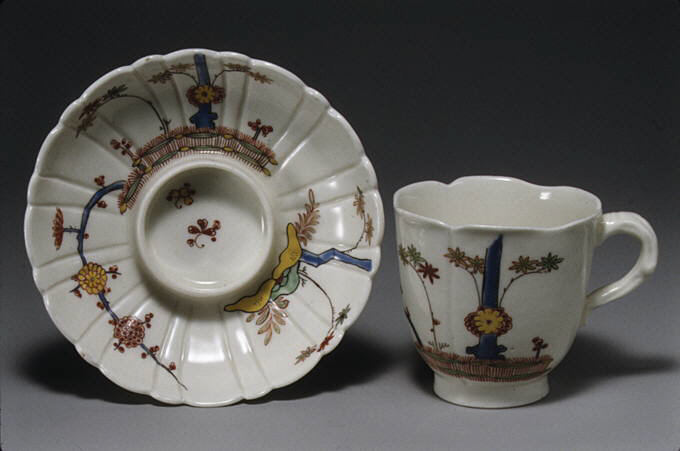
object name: cup and saucer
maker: saint-cloud factory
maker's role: factory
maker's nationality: french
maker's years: 1693-1766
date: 1730-1750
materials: soft paste porcelain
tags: flowers